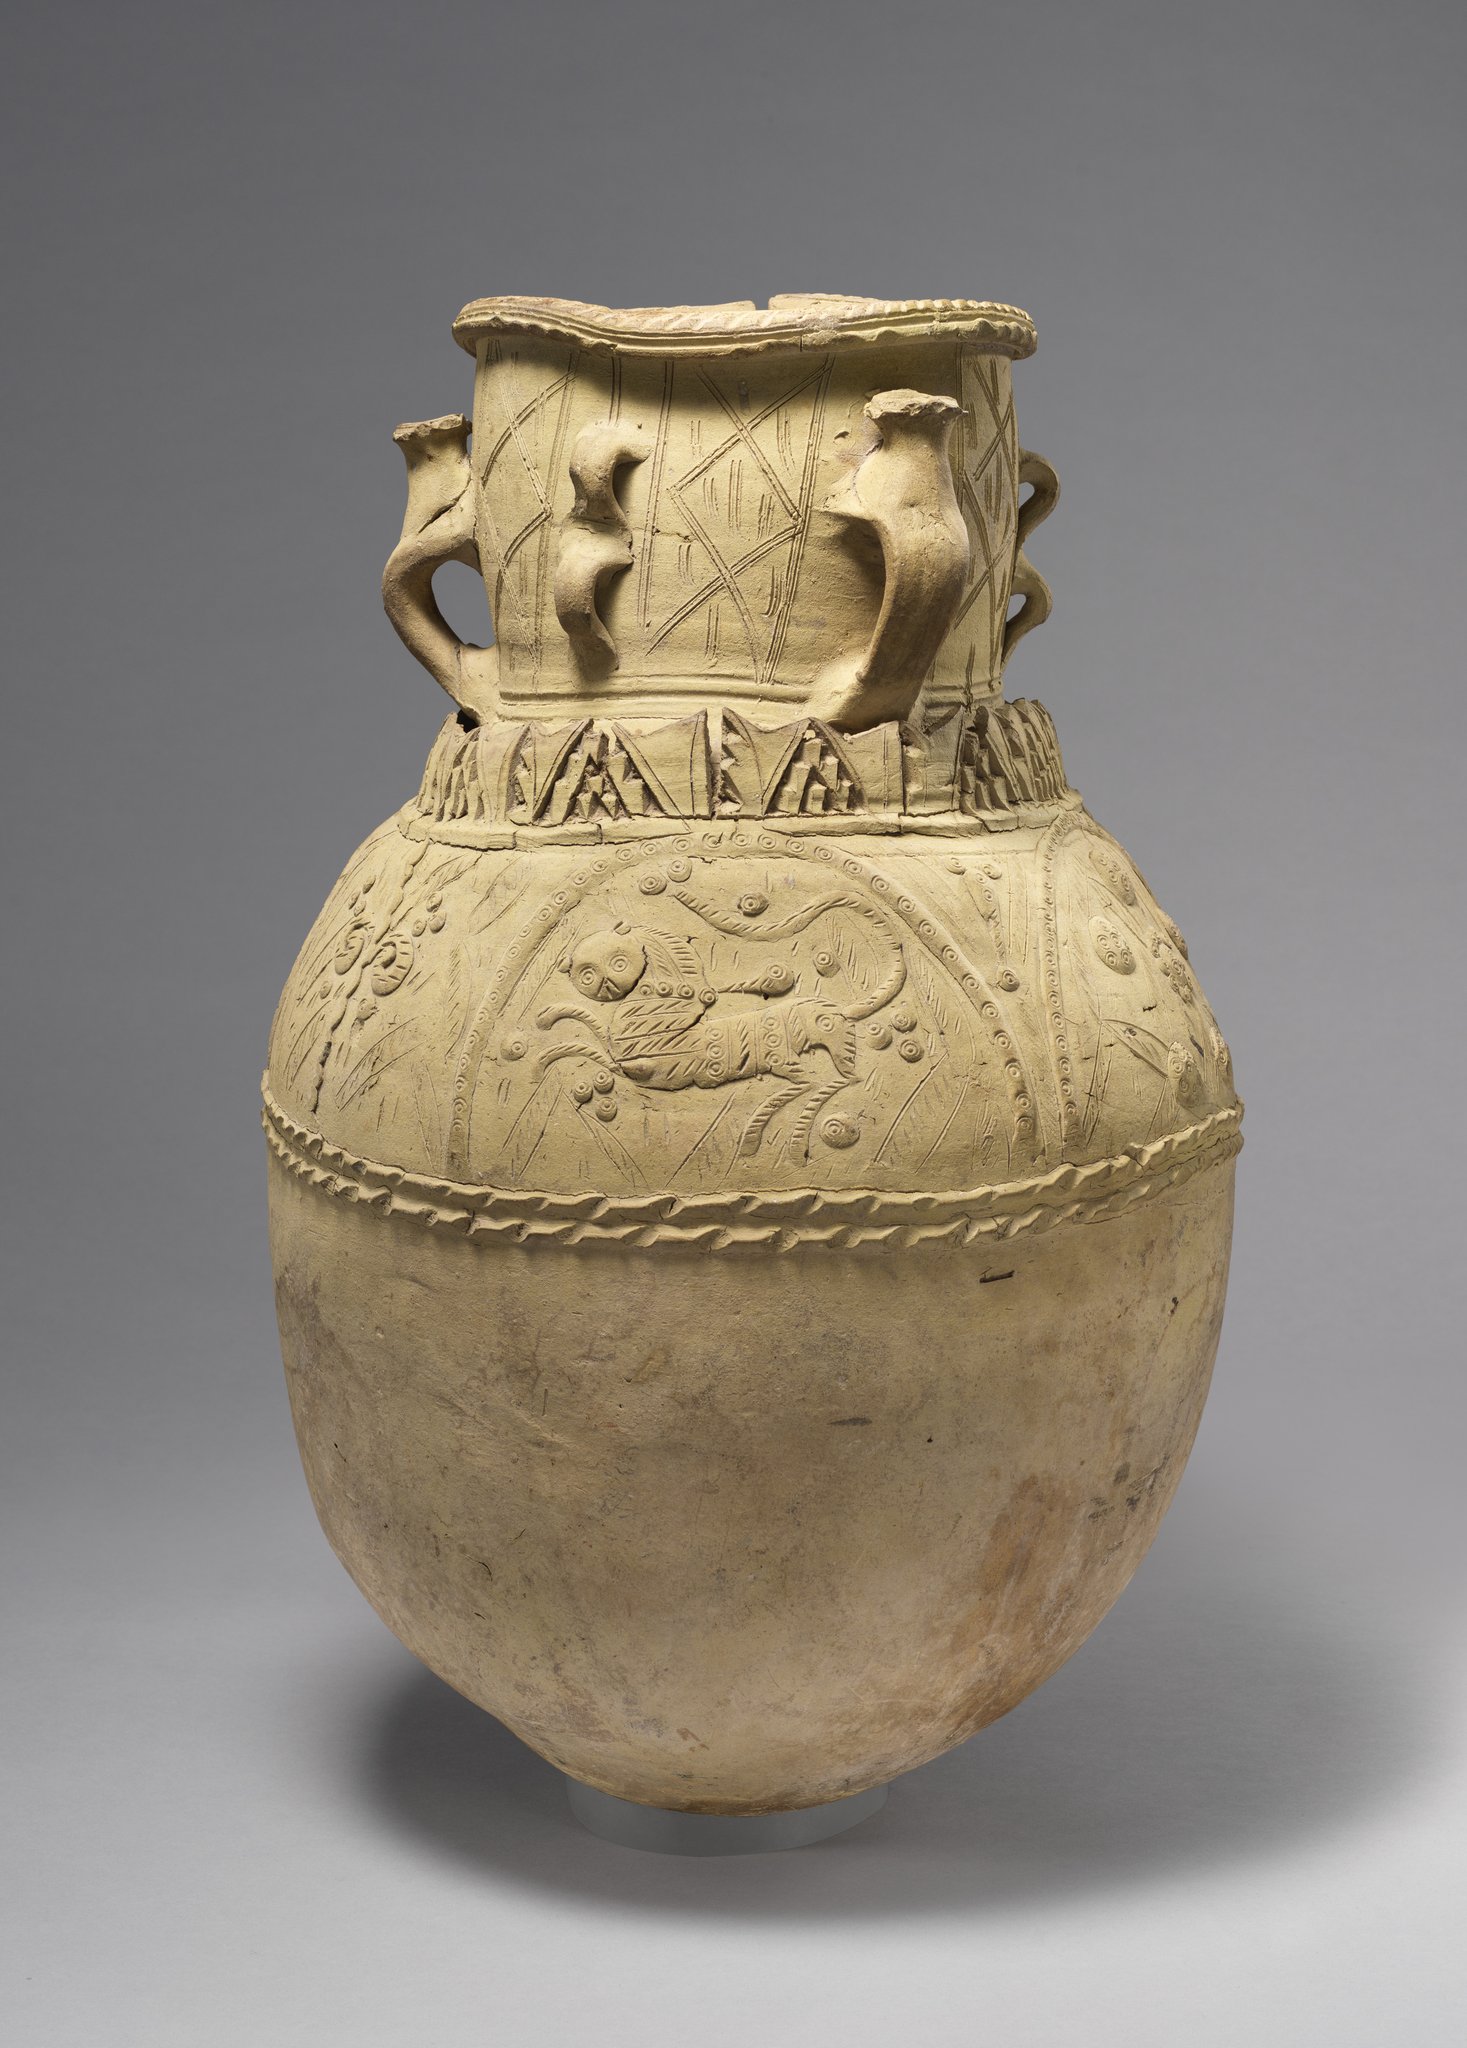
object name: jar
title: Large Storage Jar for Cool Water With a Bejeweled Lion, Hare, and Deer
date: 701-1000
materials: earthenware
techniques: incising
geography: iraq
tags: lions